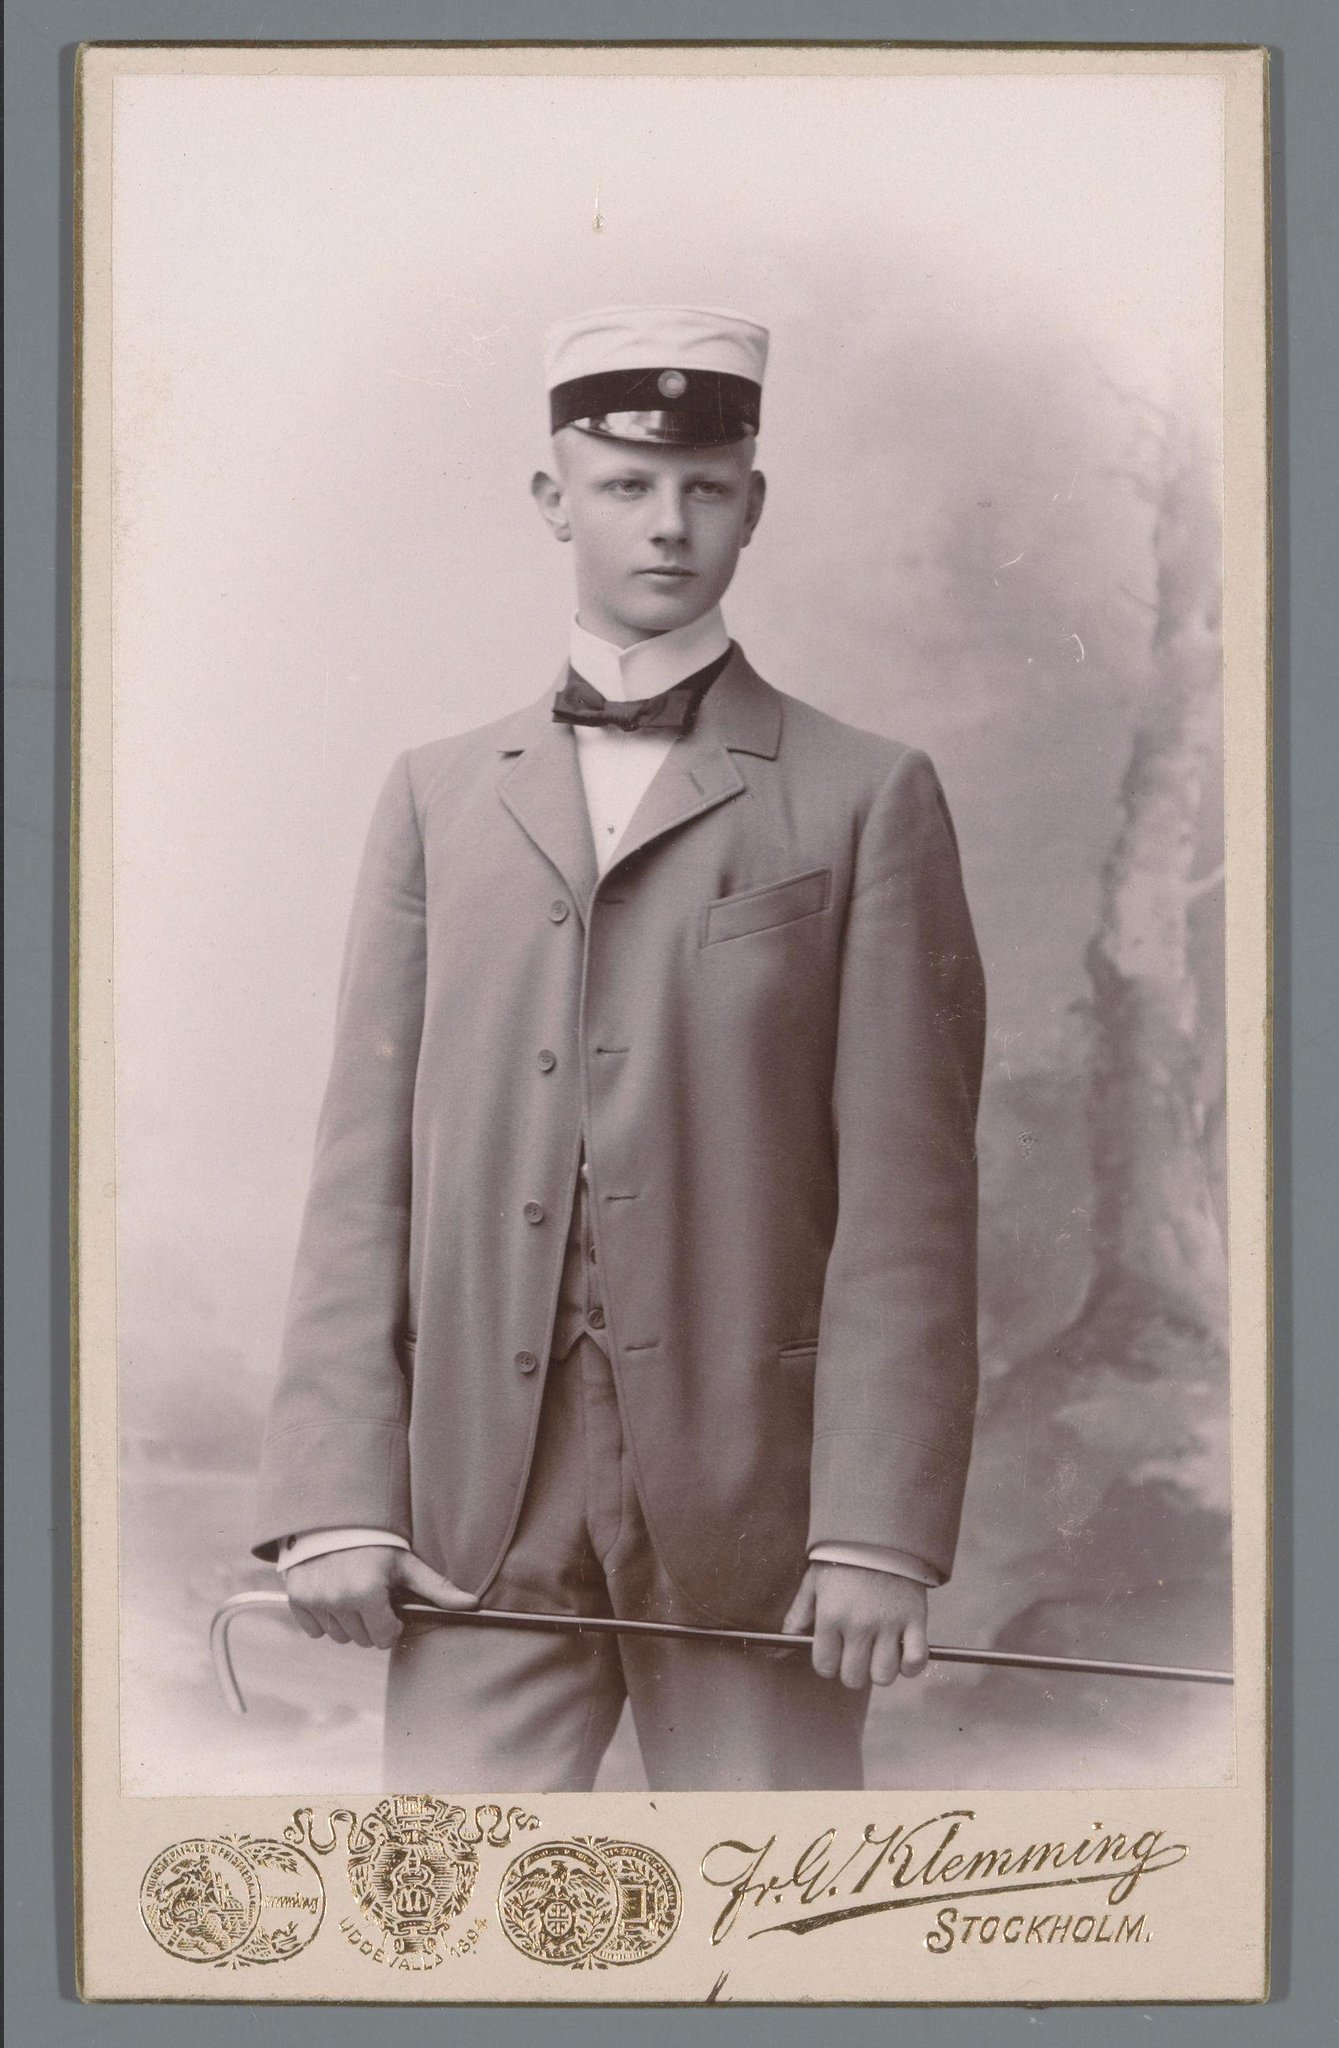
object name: photograph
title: Portret van een onbekende student met wandelstok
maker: frans gustaf klemming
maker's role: fotograaf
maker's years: 1859-1922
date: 1894-1897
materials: paper, cardboard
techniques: collodion silver print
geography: stockholm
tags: youth, adolescent, anonymous historical person portrayed, student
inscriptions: inscription: ‘Silfvermedalj Malmö 1896 och Stockholm 1897.’, address: ‘STOCKHOLM/ 38 Hamngatan 38.’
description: De geportretteerde draagt een studentmössa, een Zweedse studentenpet.